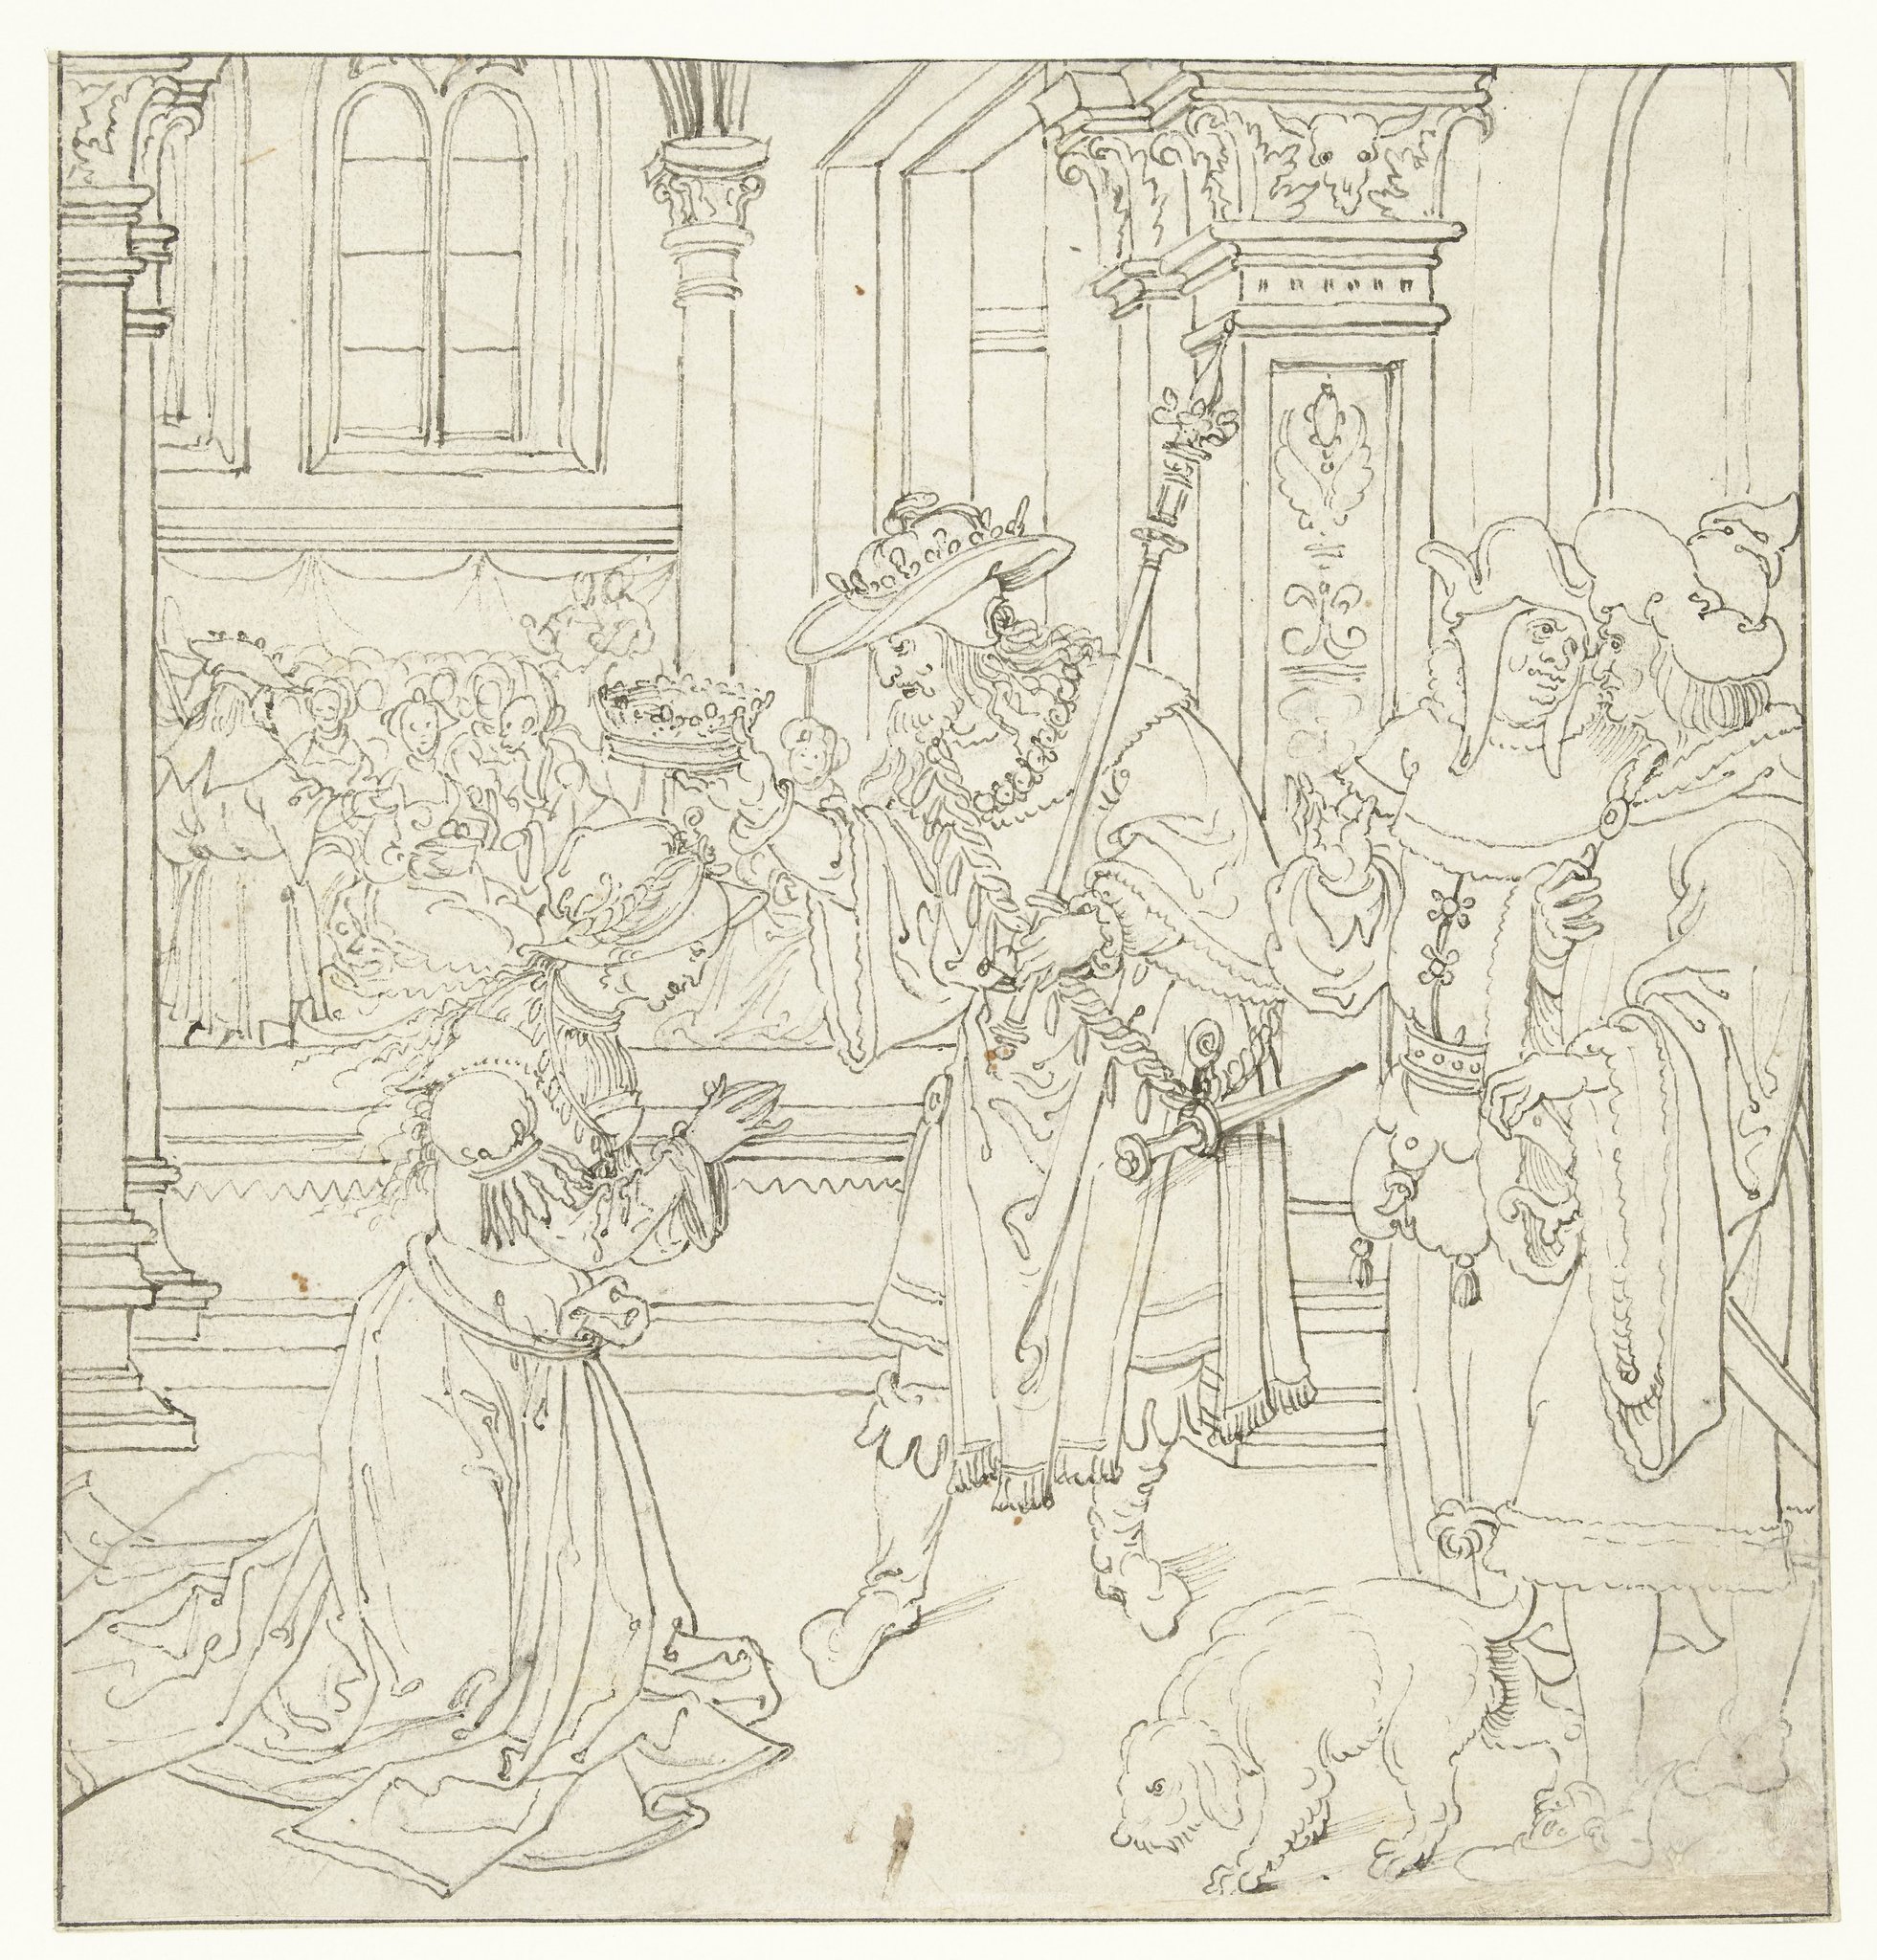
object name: drawing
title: Esther wordt door Ahasverus gekroond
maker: Anonymous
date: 1517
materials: ink, paper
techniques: pen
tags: crowning of esther